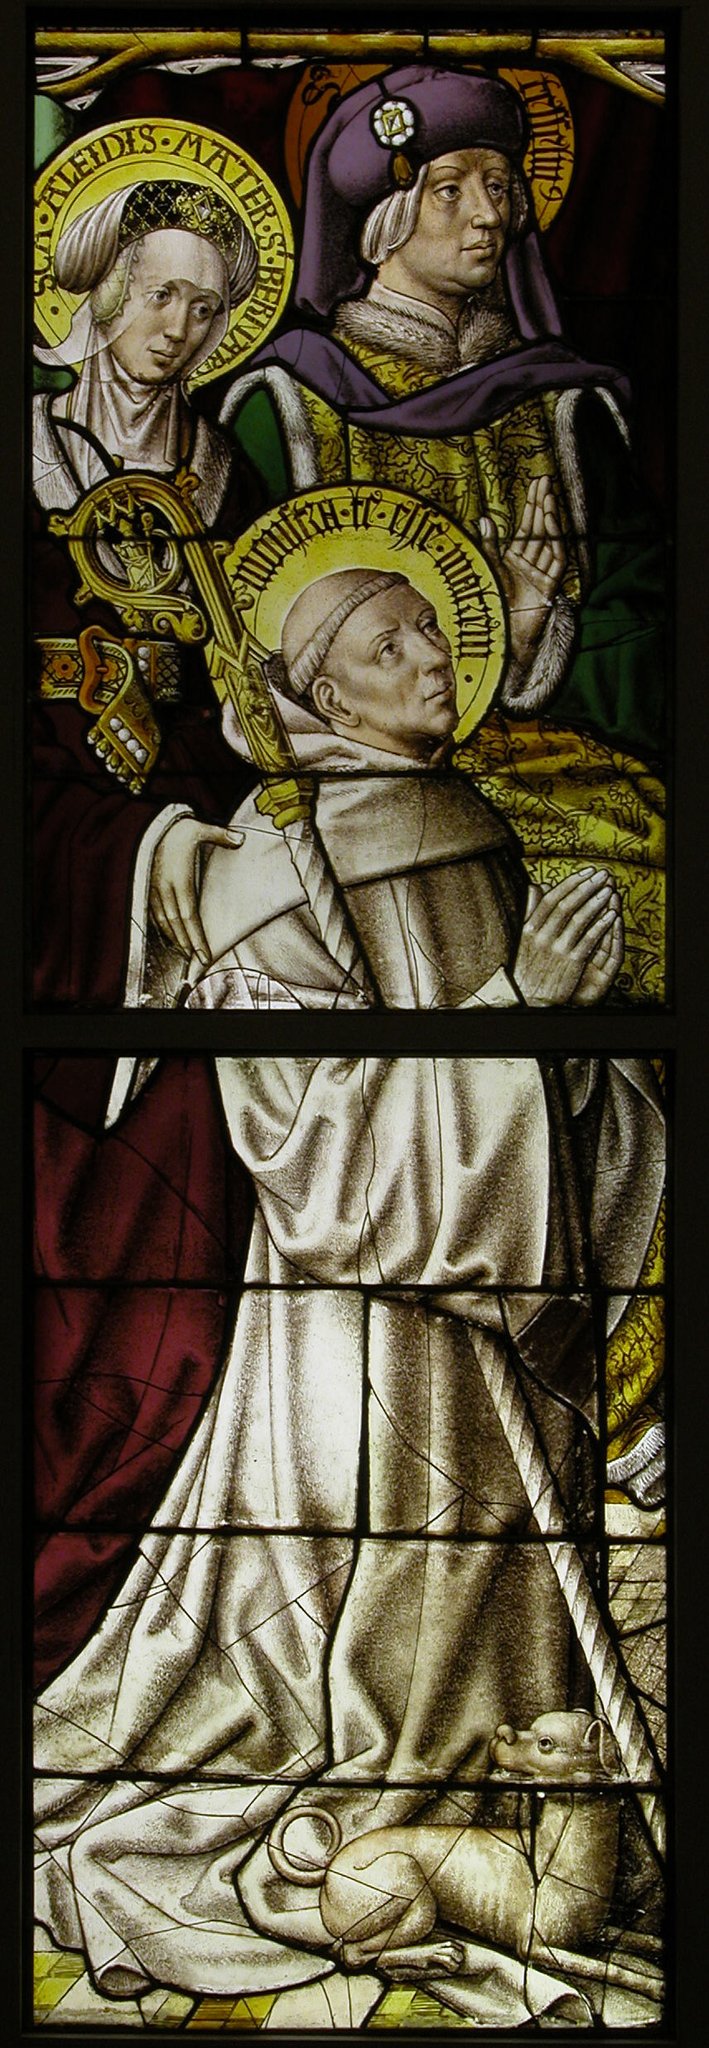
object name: panel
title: Stained Glass Panel with St. Bernard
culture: german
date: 1505-1508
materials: glass, metal, paint, pigment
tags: men,croziers